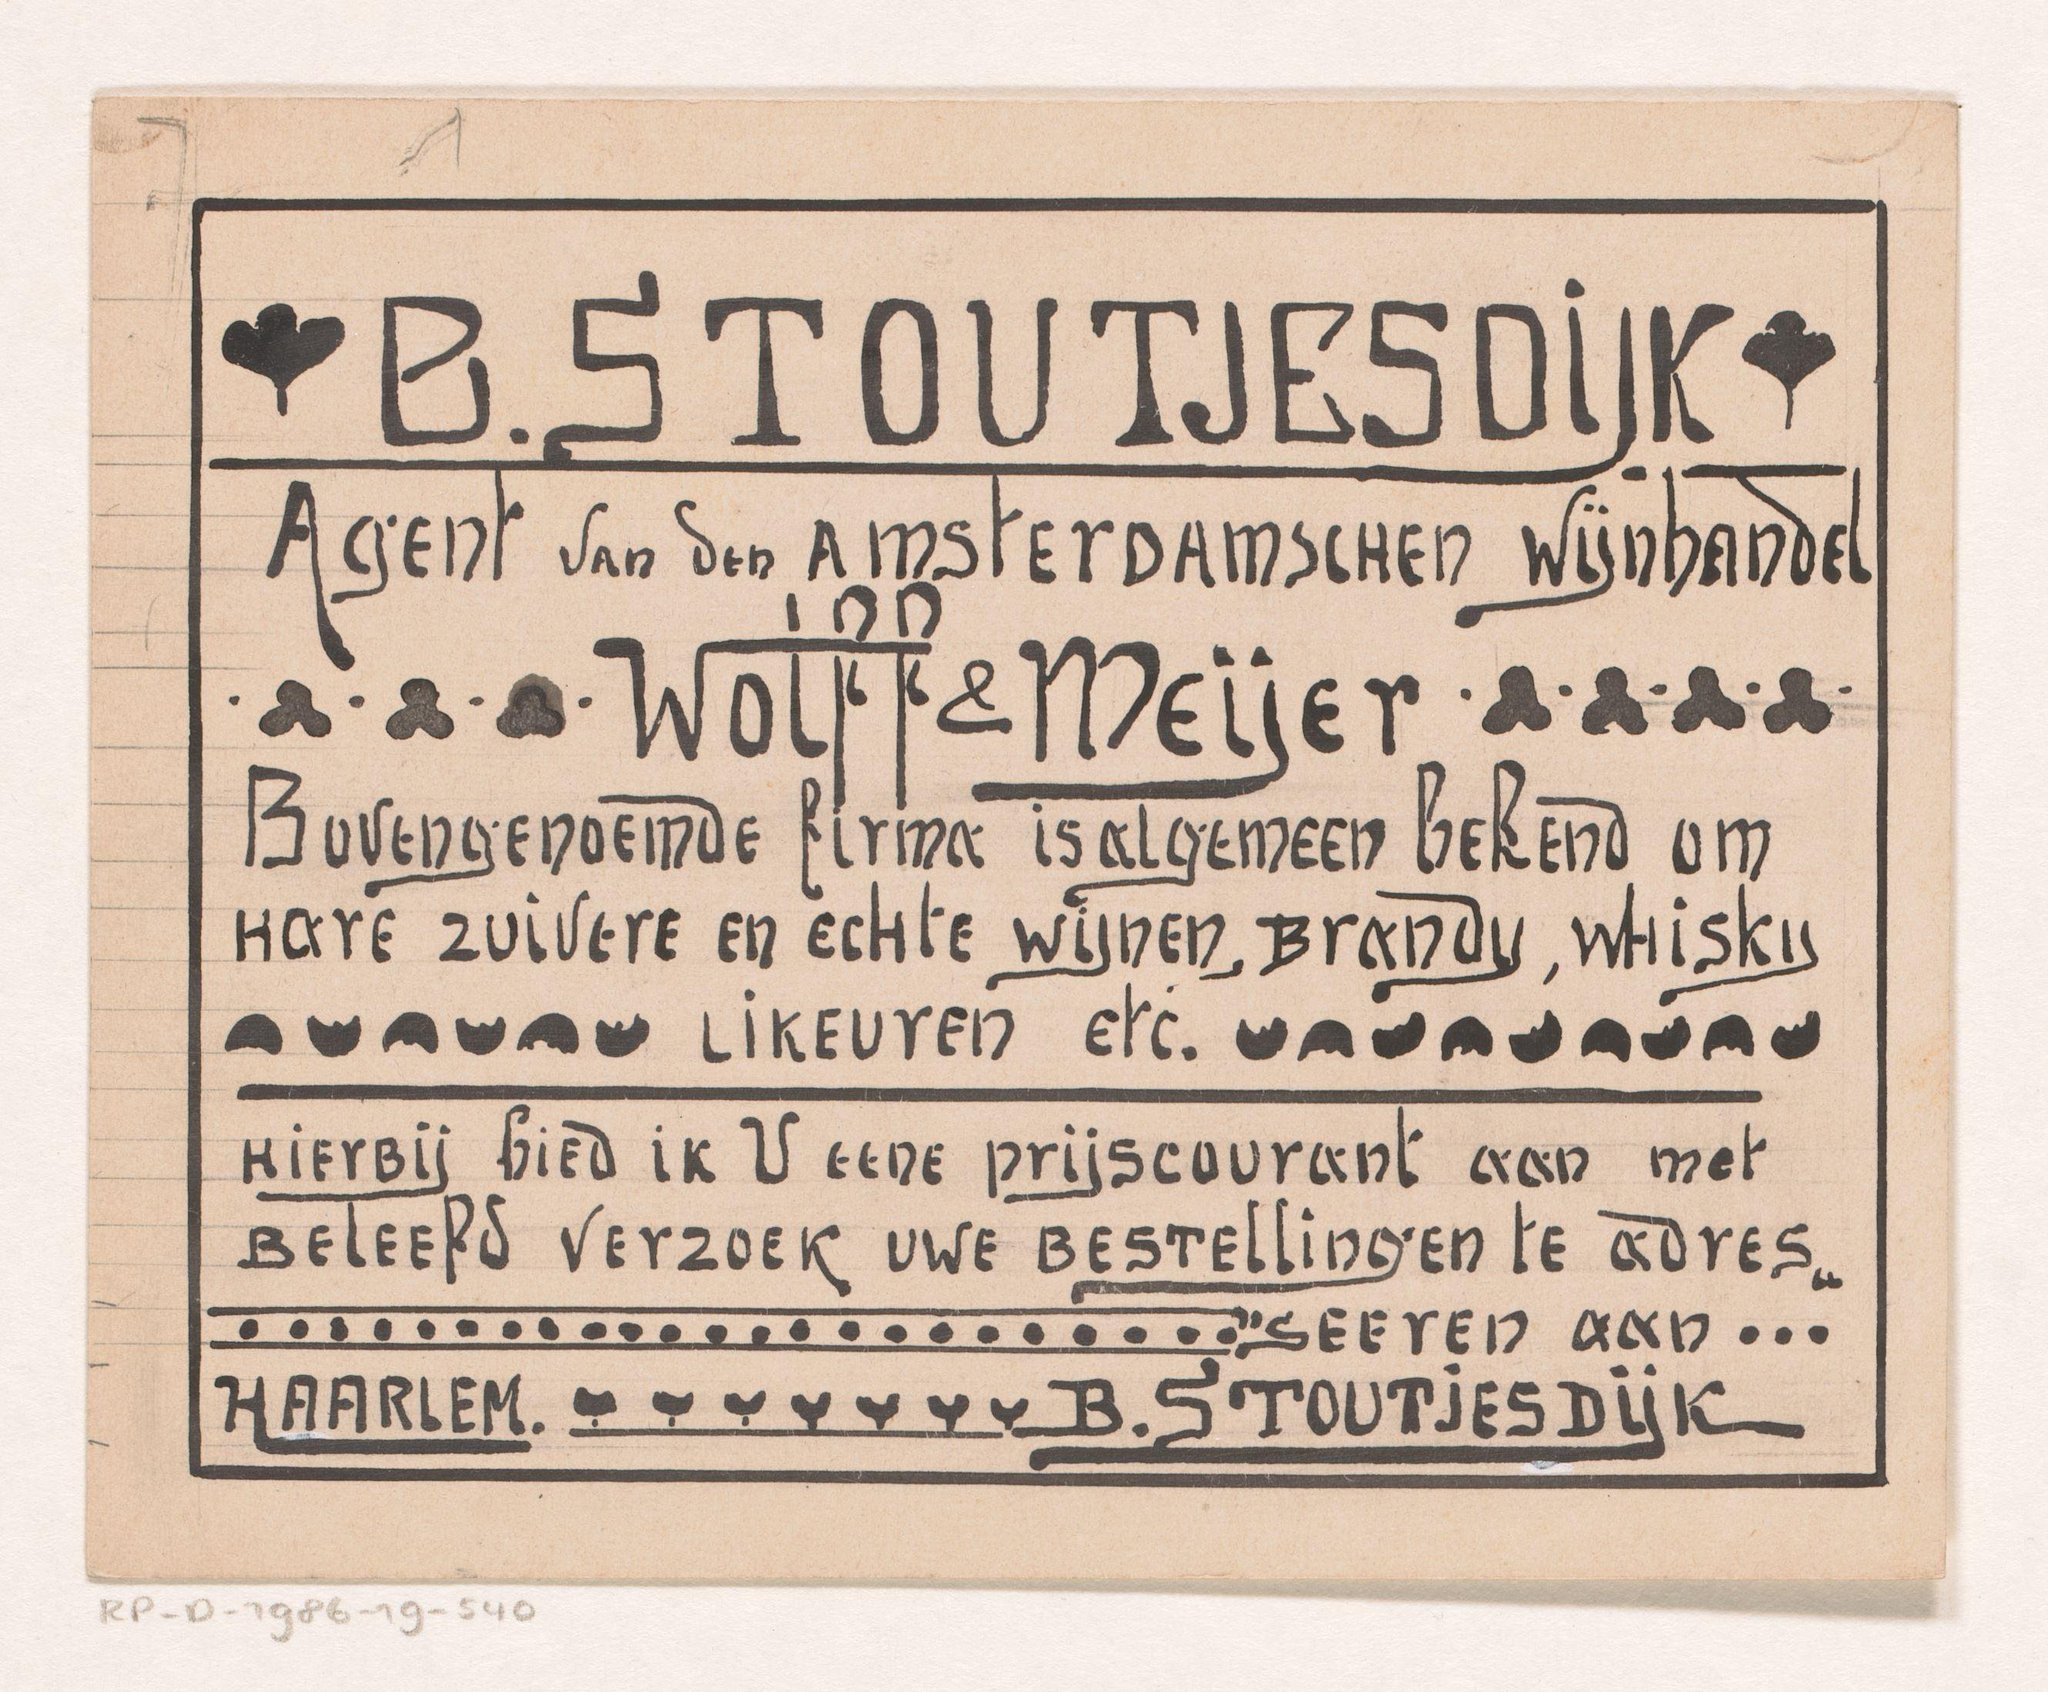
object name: design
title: Ontwerp voor een advertentie van B. Stoutjesdijk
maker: reinier willem petrus de vries (1874-1953)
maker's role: draughtsman, print maker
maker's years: 1874-1953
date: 1895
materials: paint, ink, paper, pencil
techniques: brush, pen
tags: foliage, tendrils, branches ~ ornament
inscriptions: collector's mark: ‘R:MVS.’